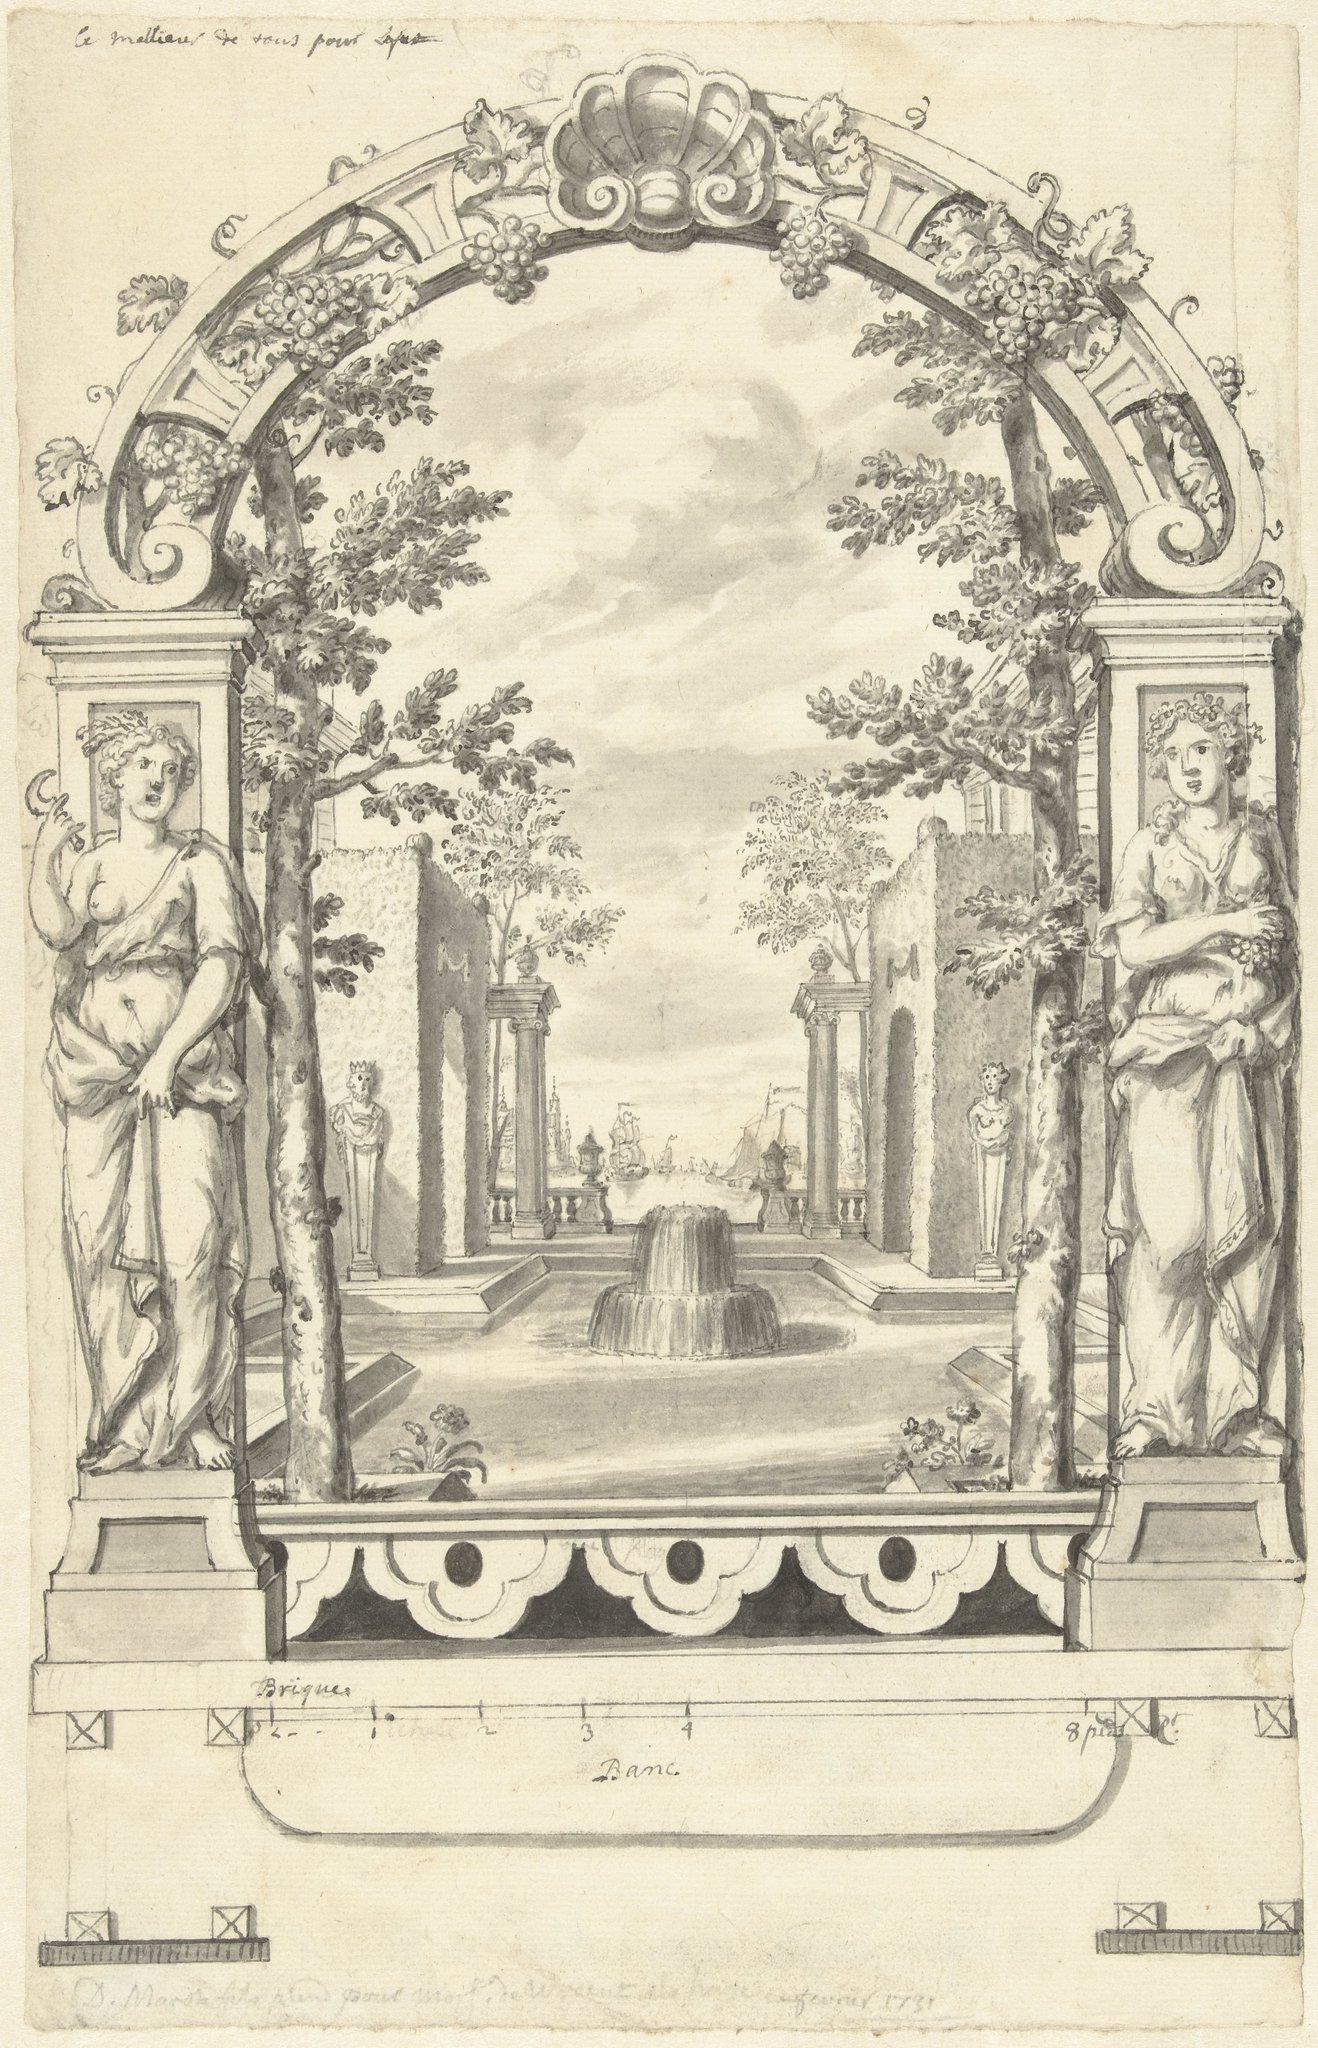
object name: drawing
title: Ontwerp voor een decoratief paneel met uitzicht op een tuin tussen standbeelden door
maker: daniël marot (ii)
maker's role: draughtsman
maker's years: 1695-1769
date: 1702-1731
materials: ink, paper, pencil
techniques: brush, pen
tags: piece of sculpture, reproduction of a piece of sculpture, wall-covering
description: Ontwerp voor een decoratief paneel (wanddecoratie?) met uitzicht op een ornamentale tuin tussen twee standbeelden door.